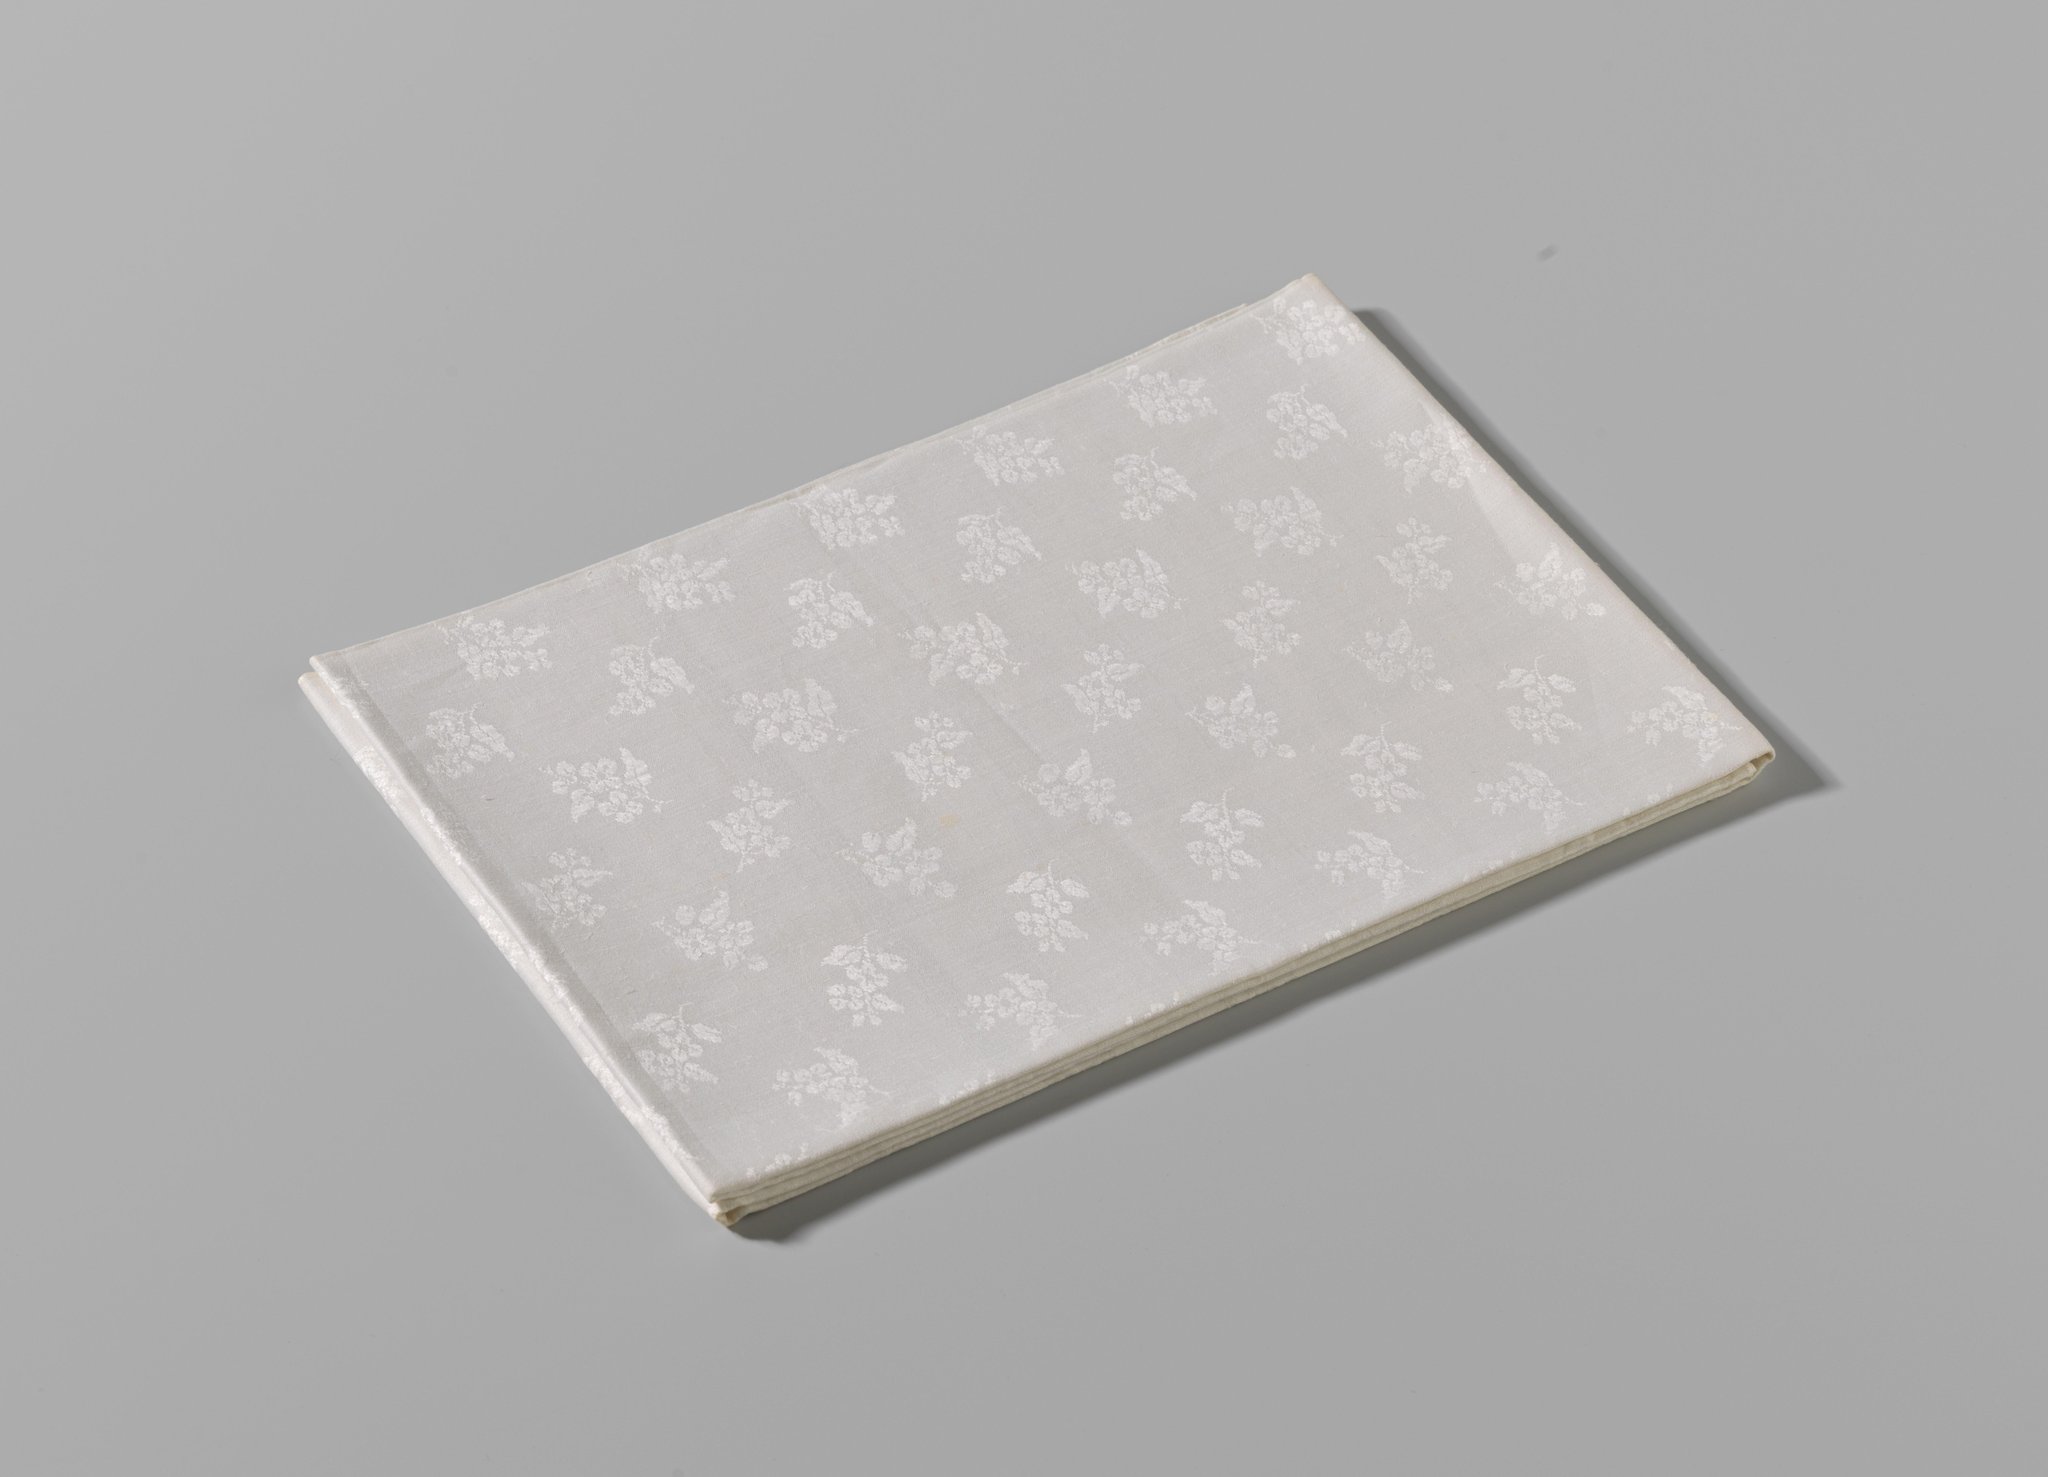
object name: napkin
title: Servet met strooibloemen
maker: Anonymous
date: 1700-1899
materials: linen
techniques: damask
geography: saxony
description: Vergelijk E. Kumsch, Leinendamastmuster des XVII. und XVIII. Jahrhunderts, Dresden 1891, Taf. 9,1.